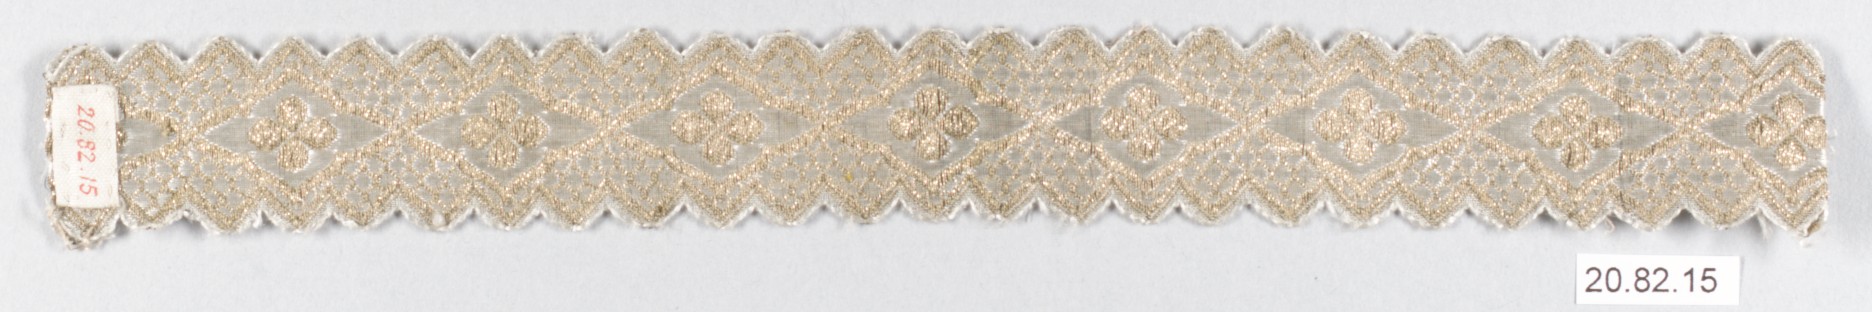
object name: ribbon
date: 1801-1833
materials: metal thread, silk